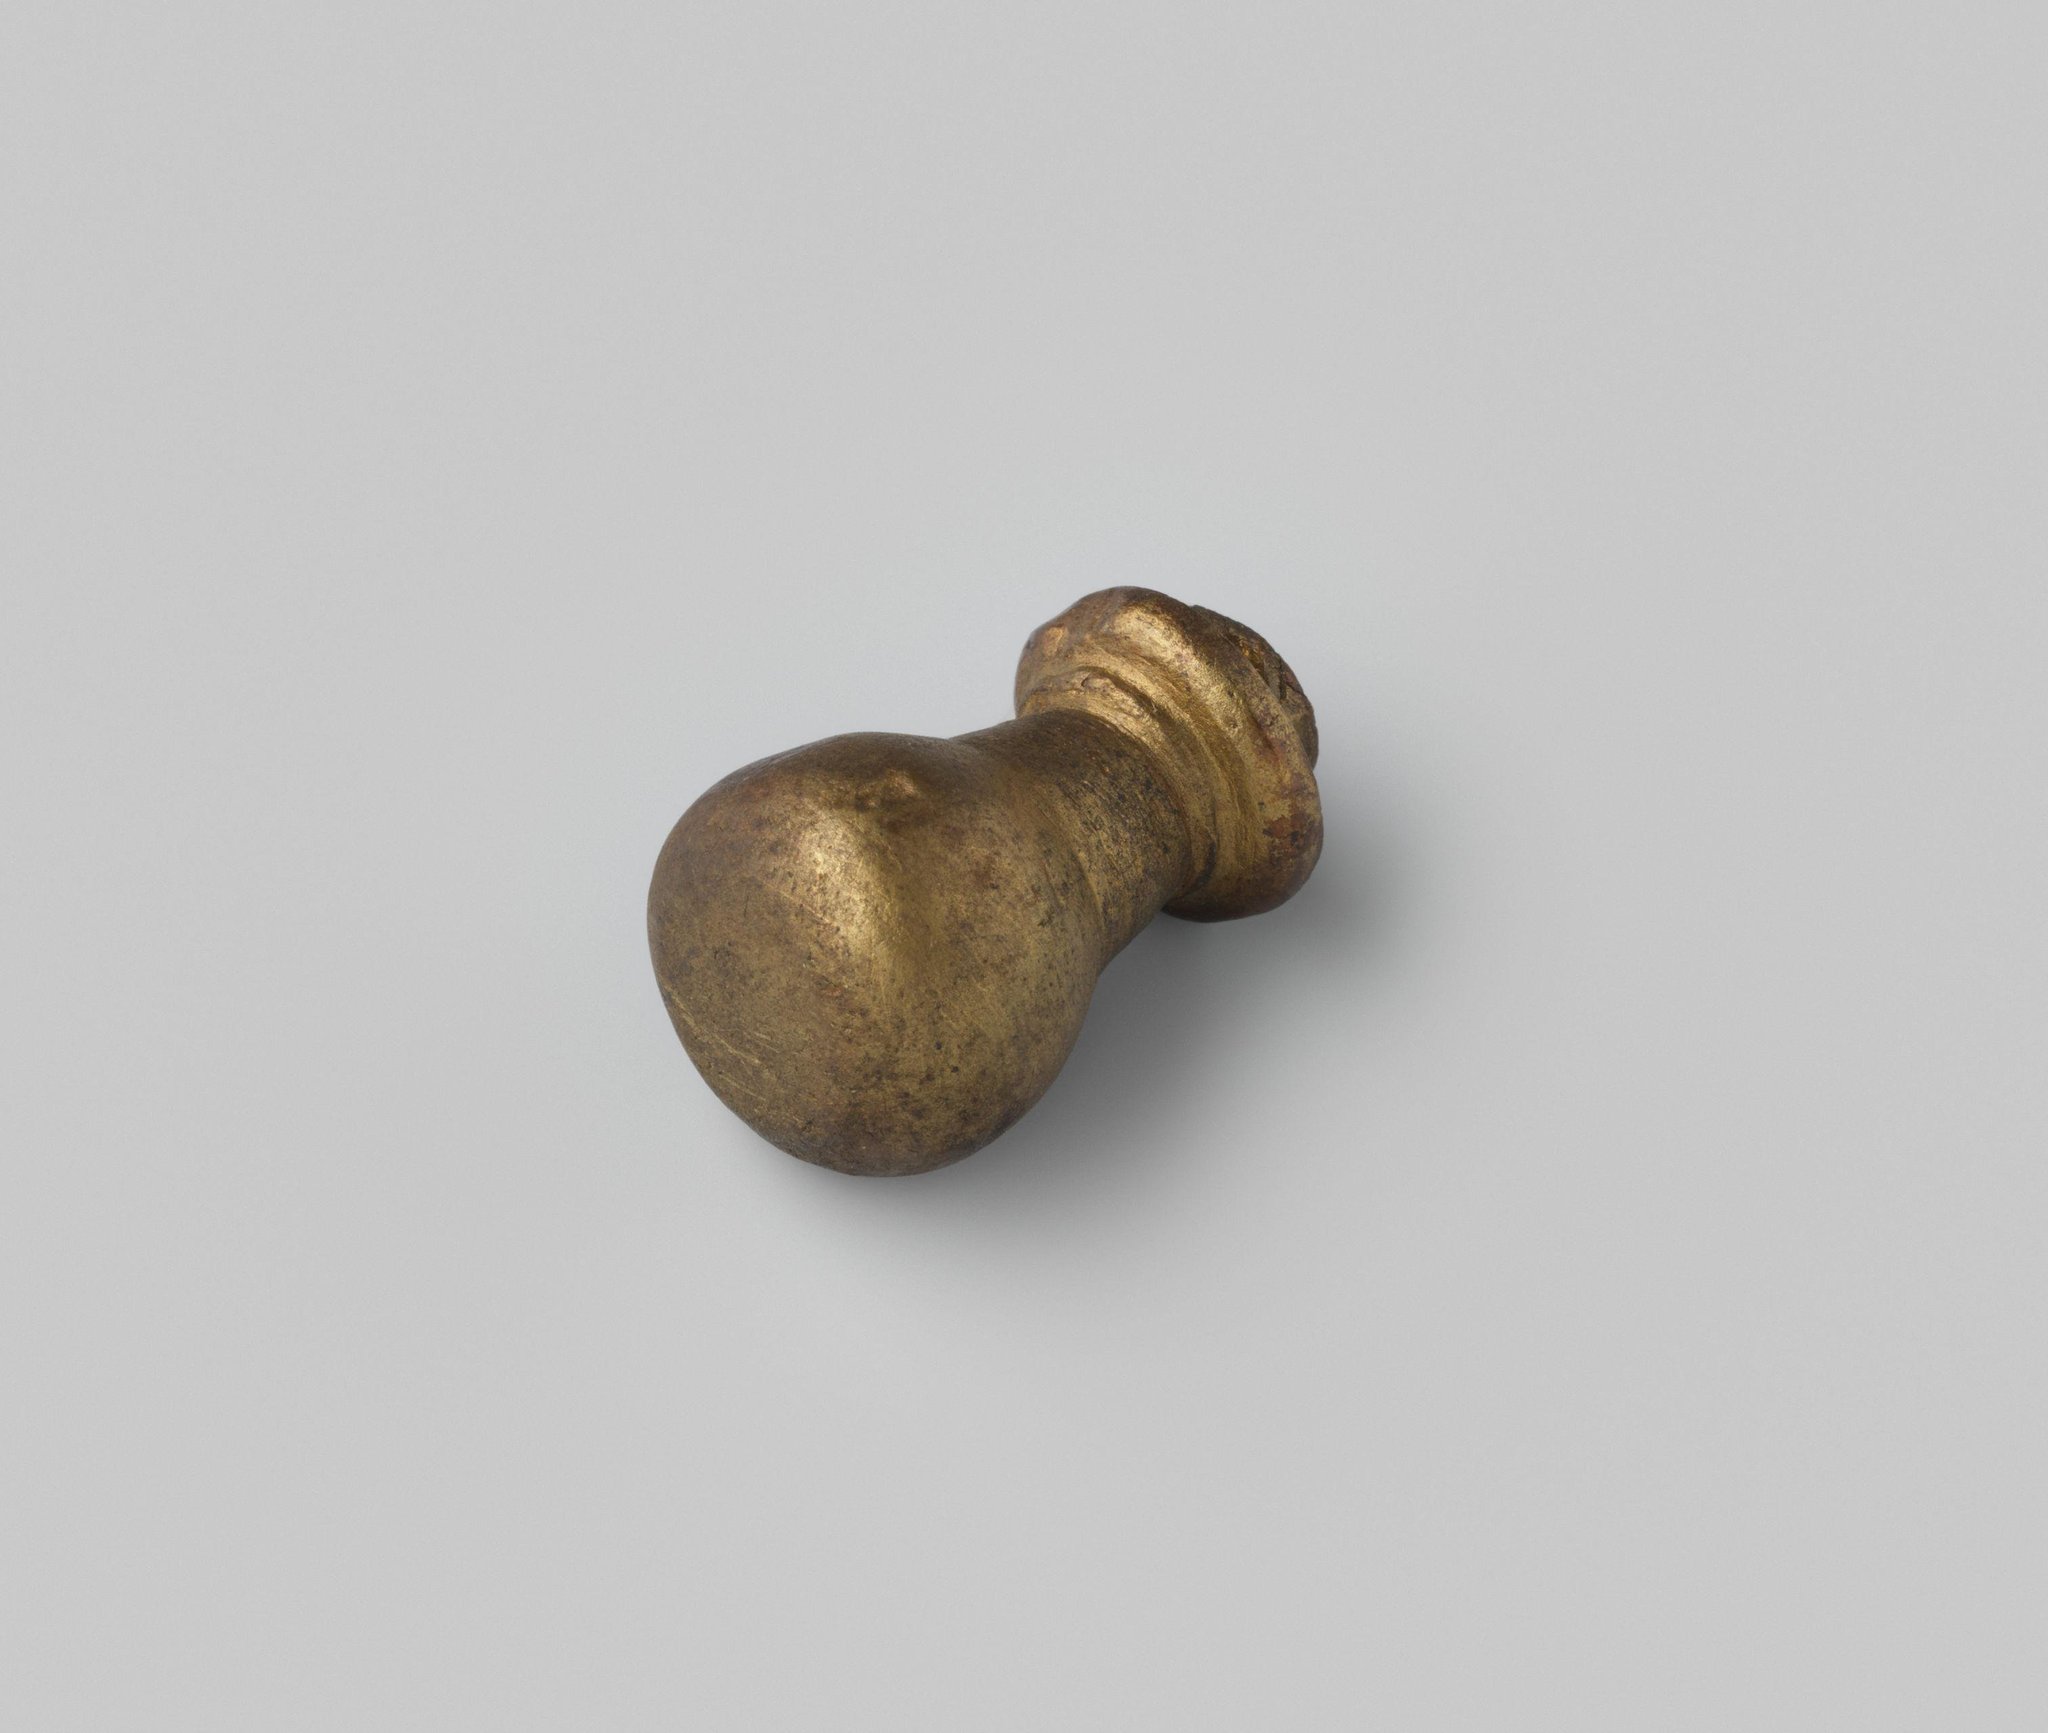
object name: knob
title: Knop uit het wrak van de Oost-Indiëvaarder Hollandia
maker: Anonymous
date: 1700-1743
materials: copper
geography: netherlands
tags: verenigde oostindische compagnie, hollandia (schip), annet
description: Fitting, knob; inverted baluster, flat top, stepped base, tenon projecting.